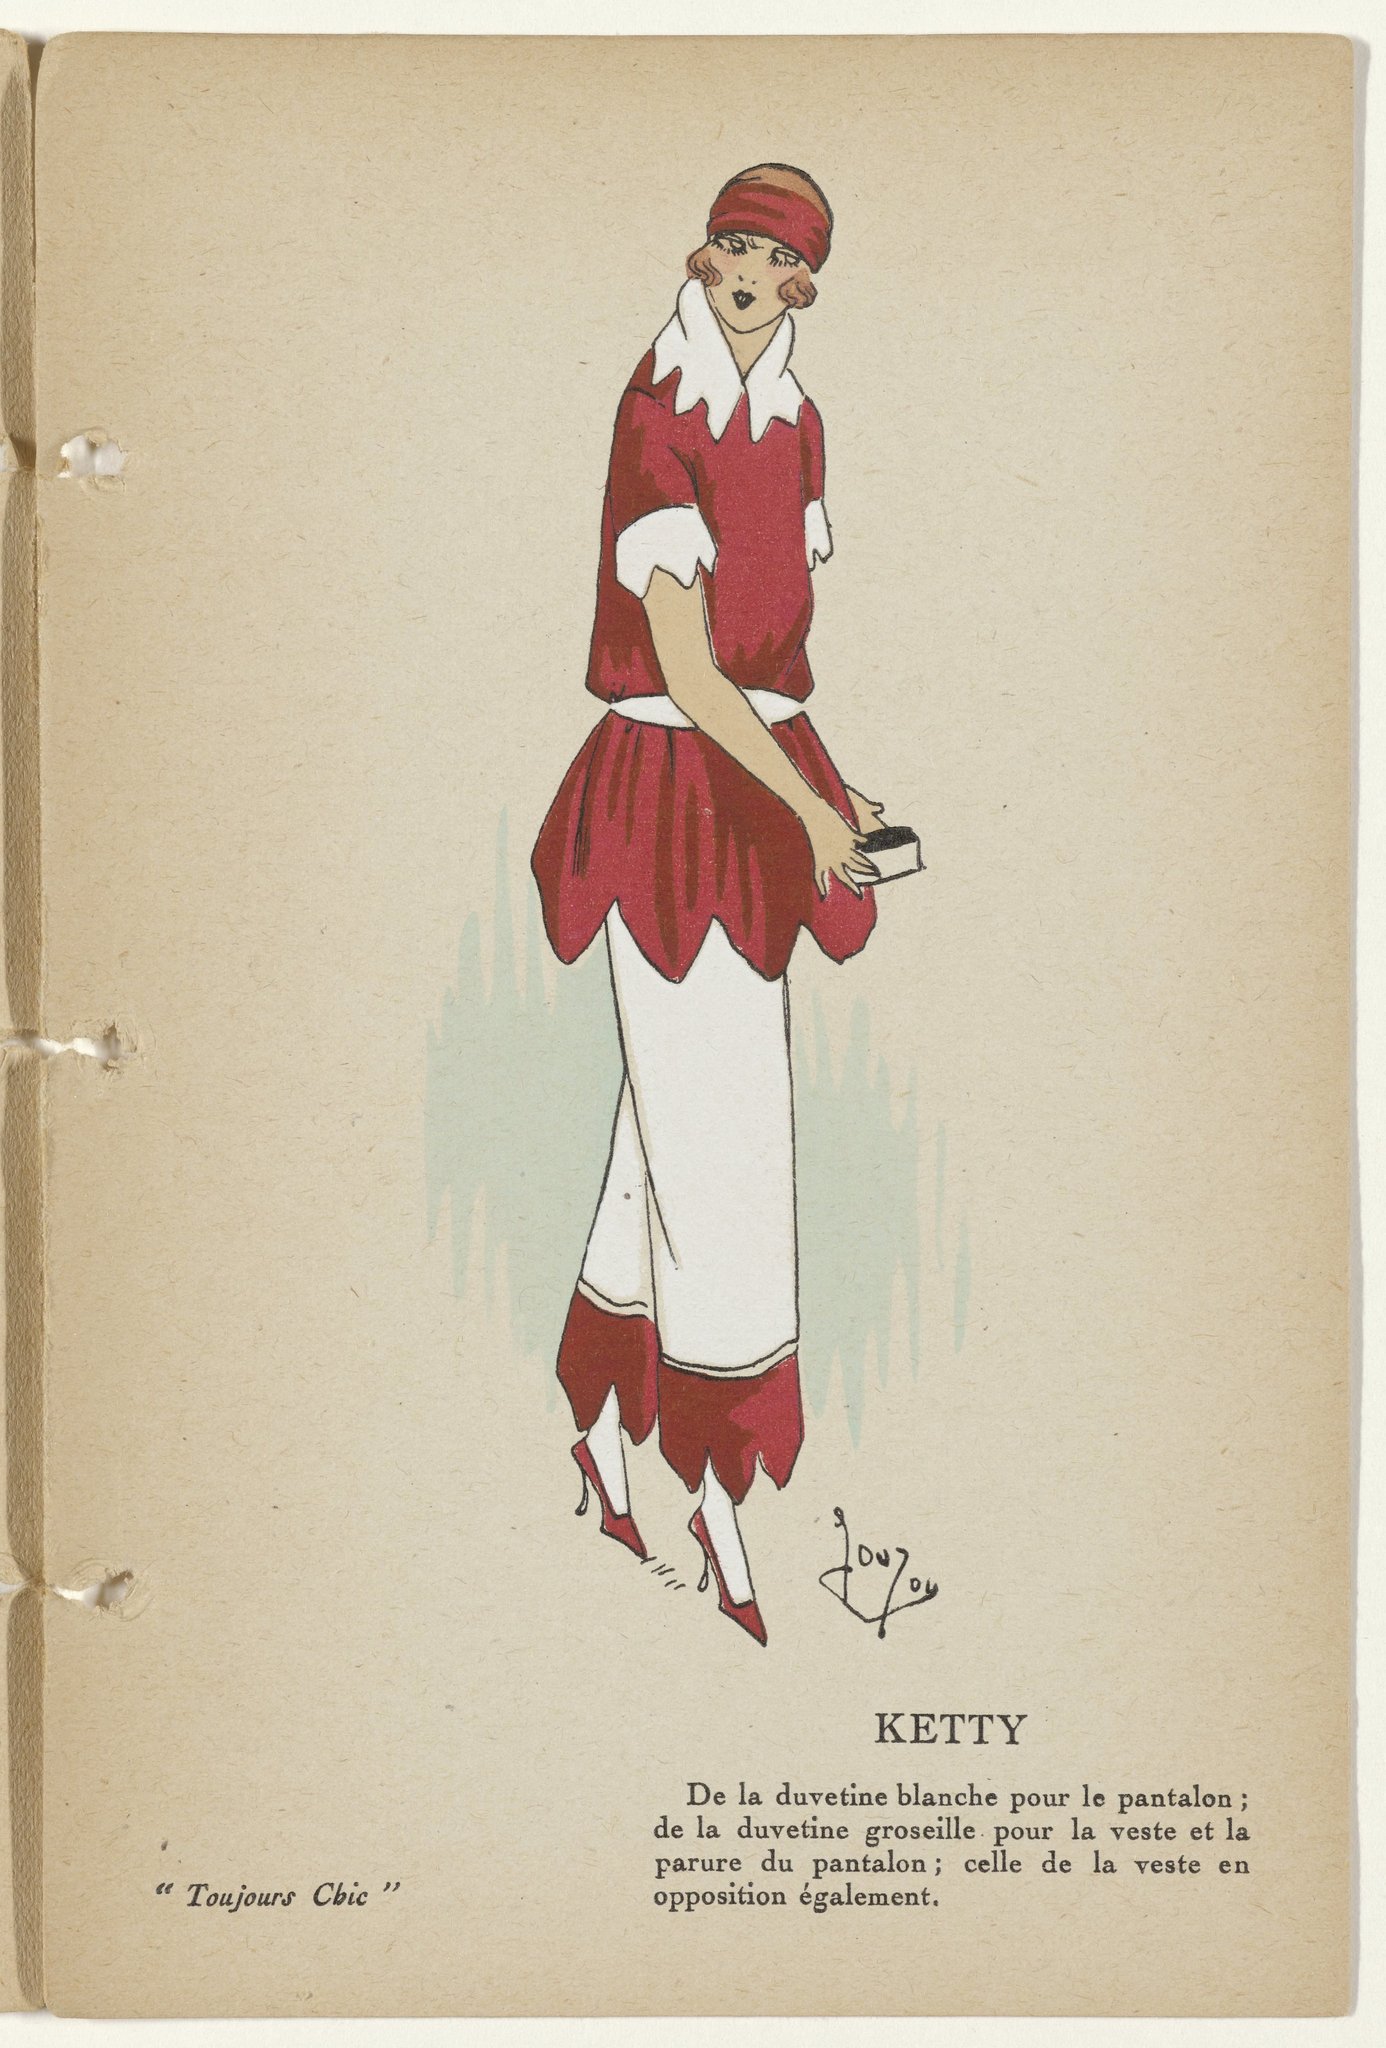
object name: fashion print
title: Toujours Chic Les Deshabillés, Hiver 1921-1922: Ketty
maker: g-p. joumard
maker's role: publisher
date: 1921-1922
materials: paper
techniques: letterpress printing, pochoir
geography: paris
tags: fashion plates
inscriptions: date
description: Prent uit Catalogus "Toujours Chic" waarin een overzicht van de wintermode 1921-1922.